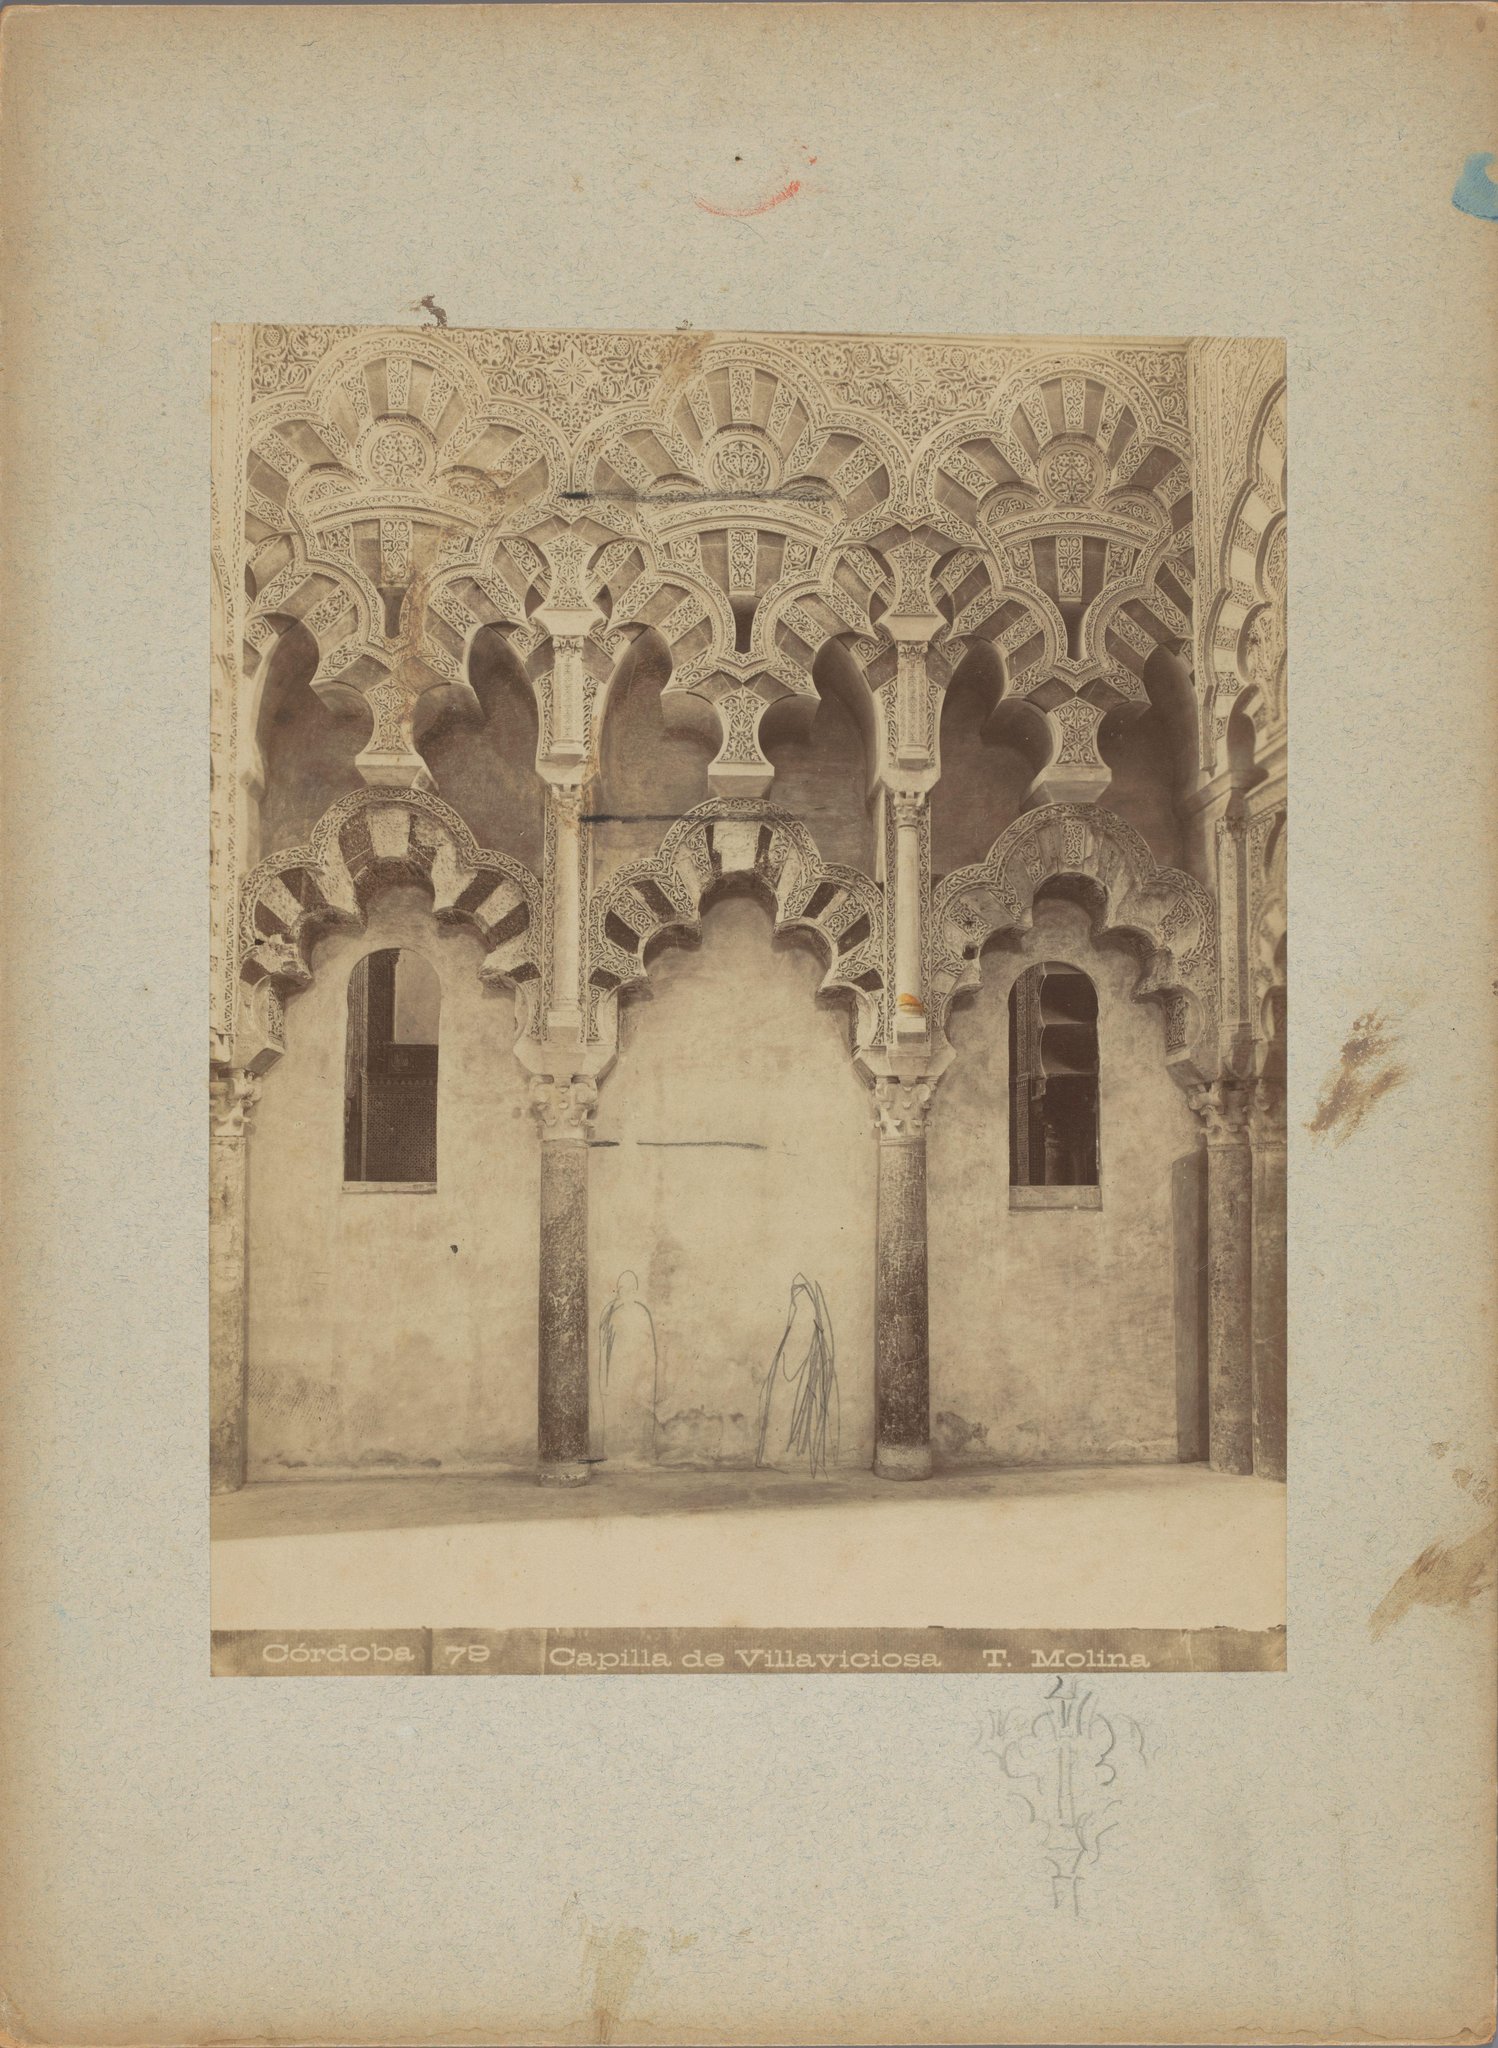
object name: photograph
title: Córdoba, Capilla de Villavicioso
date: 1890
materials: cardboard, pencil, photographic support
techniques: albumen print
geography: córdoba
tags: parts of church interior: chapel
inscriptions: inscription: ‘Cordoba 79’, inscription: ‘Capilla de Villavicioso’, name: ‘T. Molina’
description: Capilla de Villavicioso, kapel in de Mezquita kathedraal in Córdoba. Op de foto zijn twee menselijke figuren getekend, in de marge is een deel van de architectuur op de foto nagetekend.